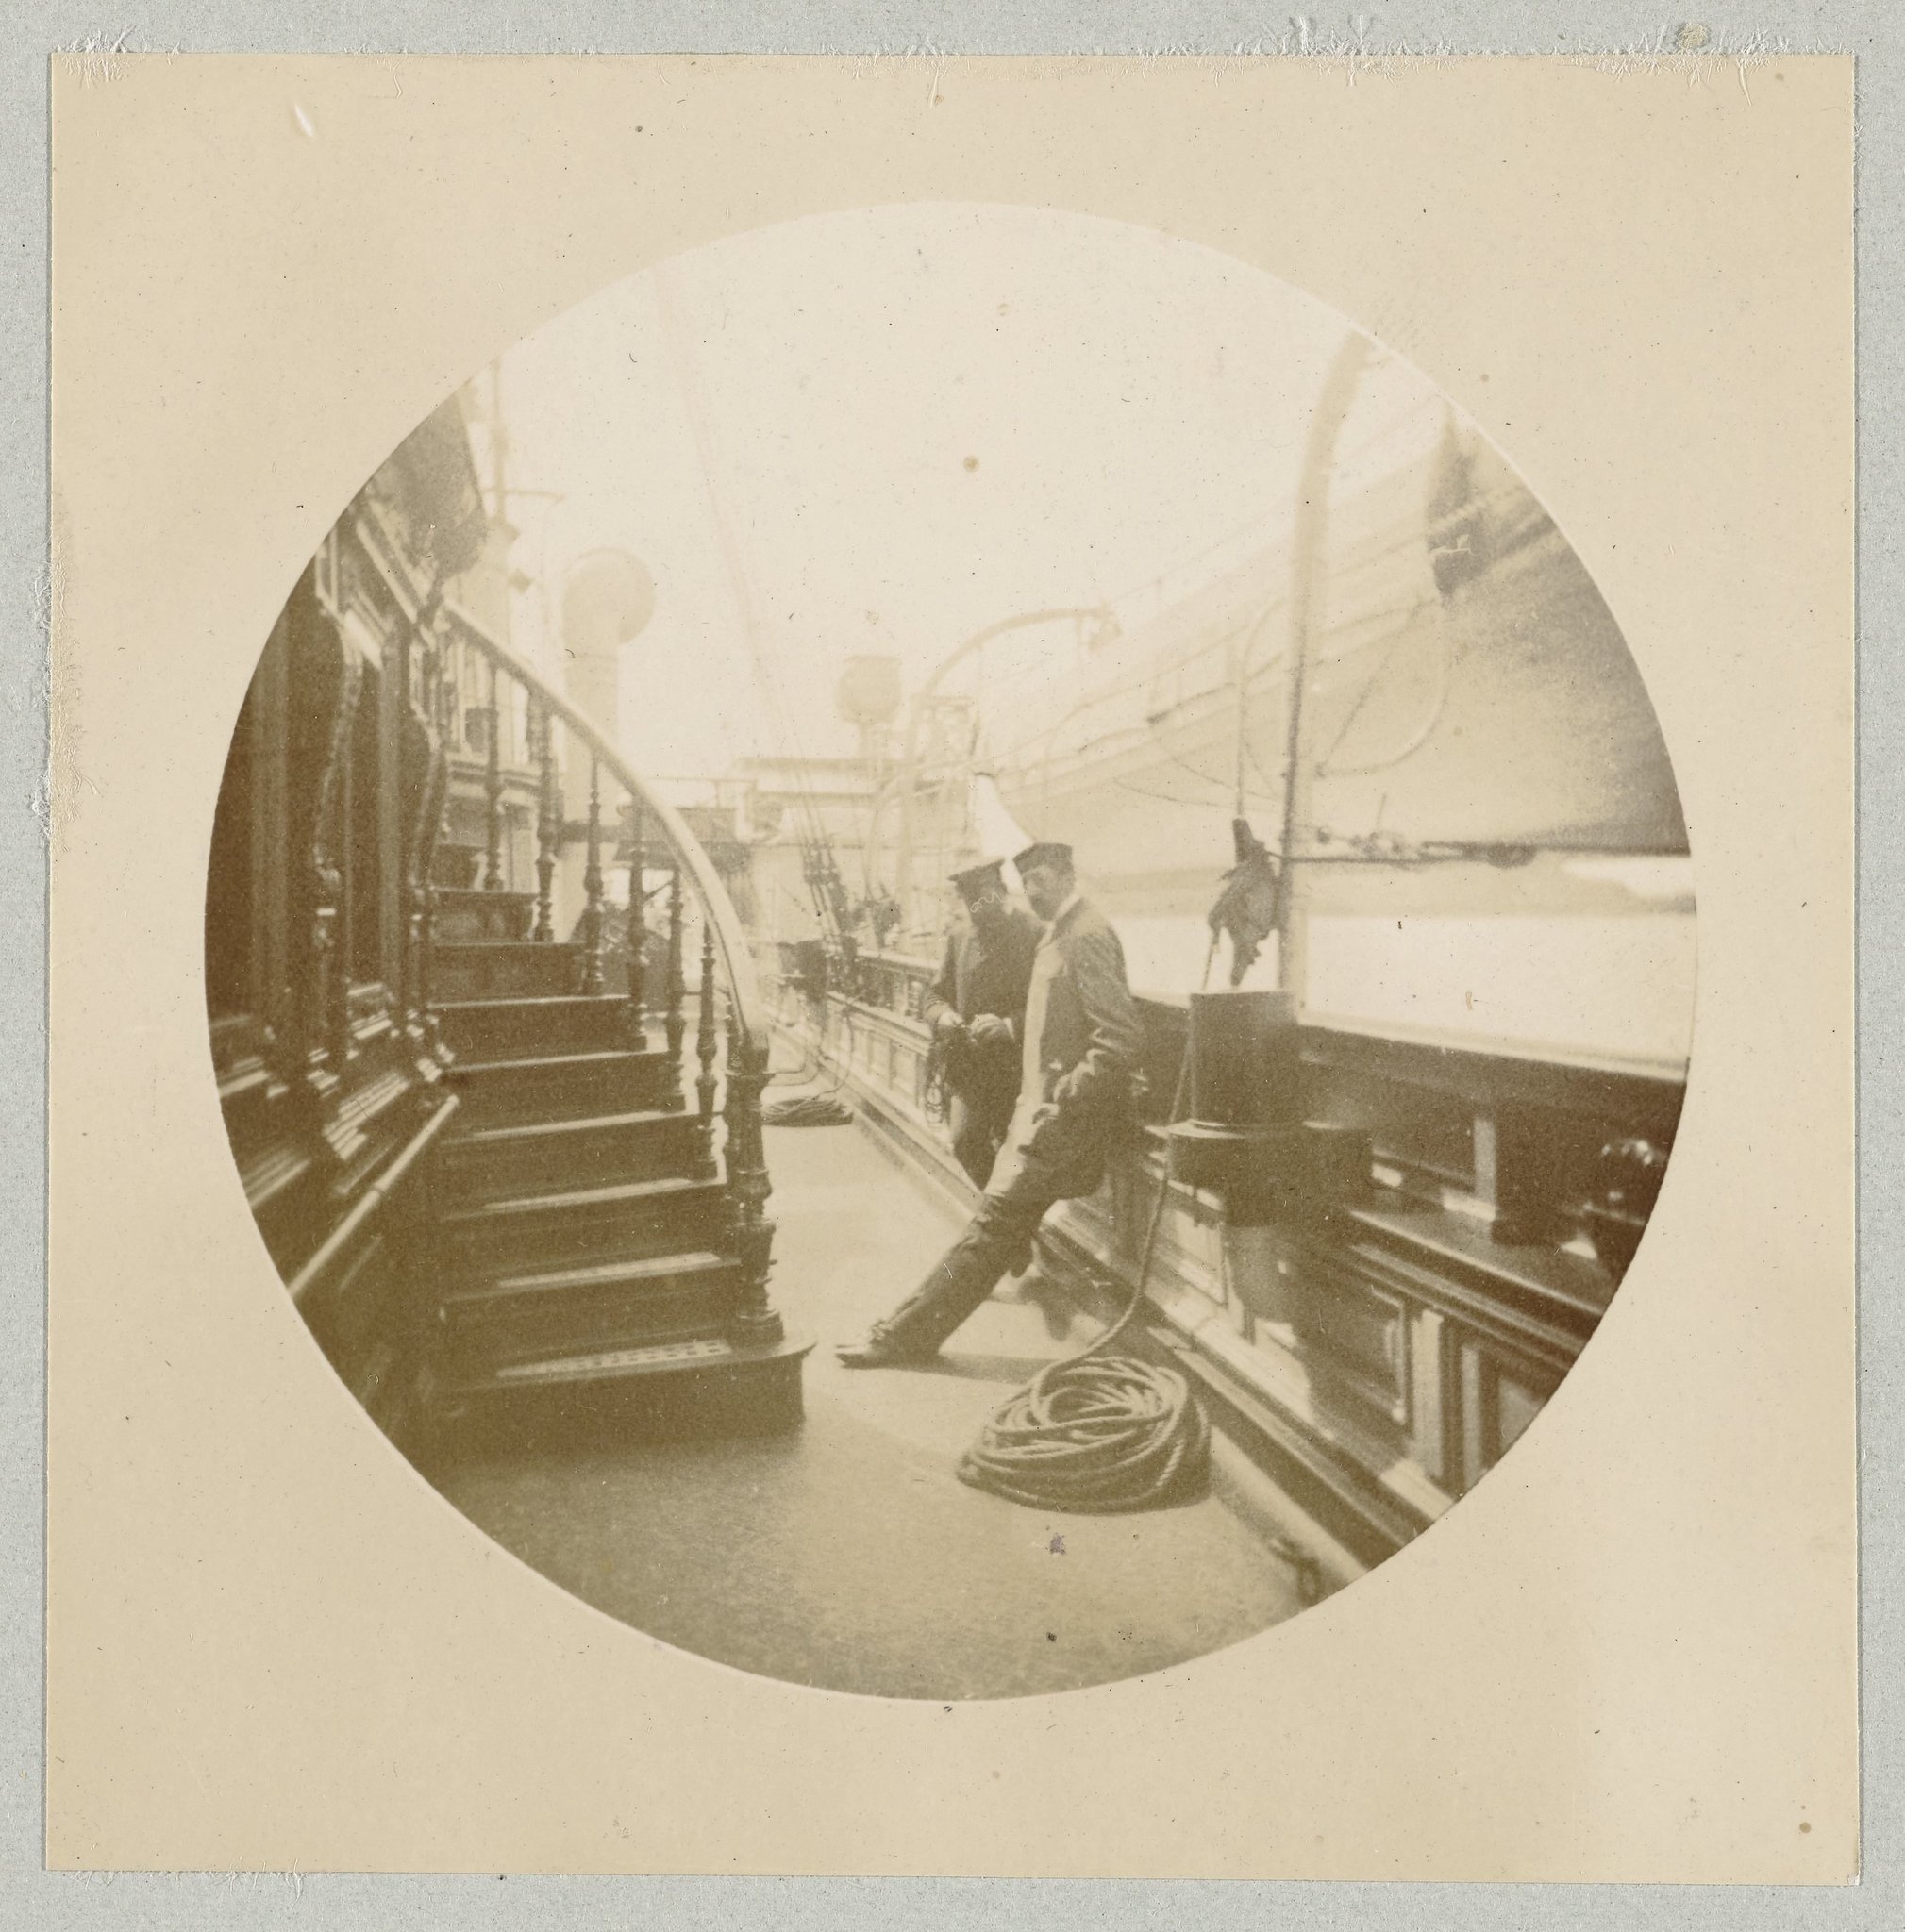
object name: photograph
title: Twee mannen in gesprek aan de railing van een schip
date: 1807-1889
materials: cardboard, paper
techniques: gelatin silver print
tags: wilhelm ii (keizer van duitsland), norway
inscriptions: number: ‘23’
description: De afdruk van de foto is rond, het papier vierkant. foto gemaakt met Nr. 1 Kodak Camera